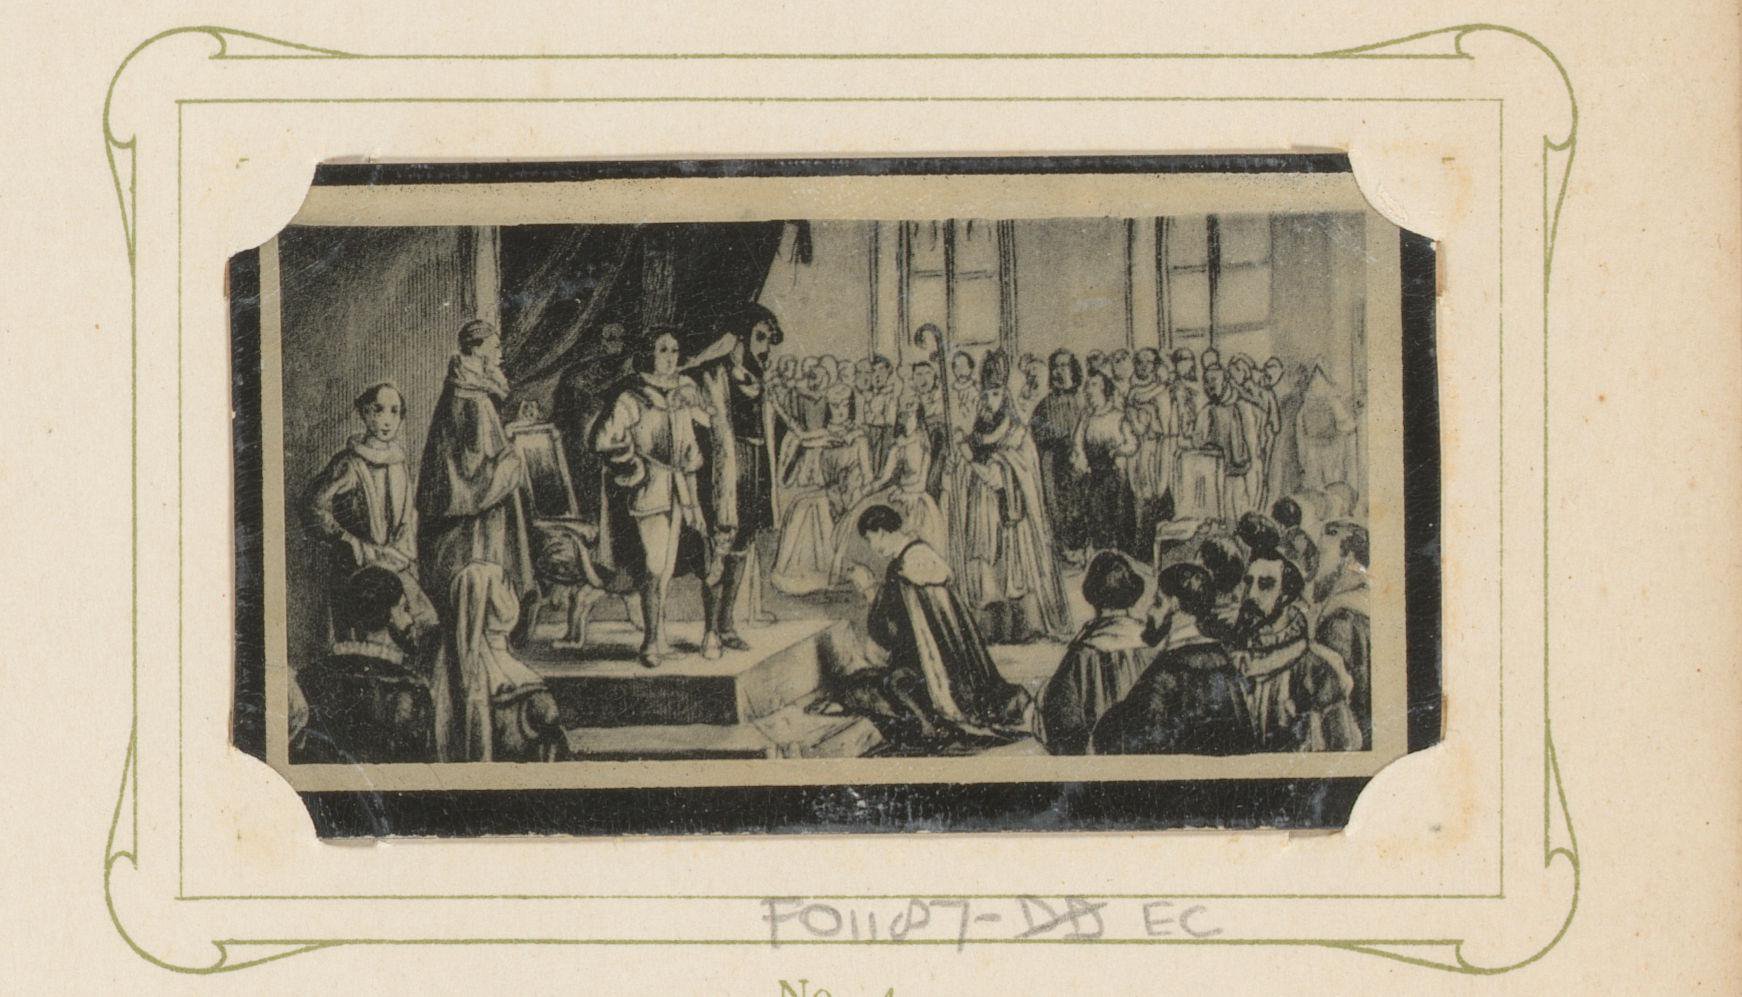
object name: photomechanical print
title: Reproductie van een tekening van keizer Karel V die aftreedt als heer der Nederlanden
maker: Anonymous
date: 1905-1906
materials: paper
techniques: photograph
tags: ghent, charles v (holy roman emperor and king of spain), voluntary abdication (of a ruler)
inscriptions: inscription: ‘No. 4./ Karel V doet afstand van de regeering.’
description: Deze prent maakt deel uit van een album.